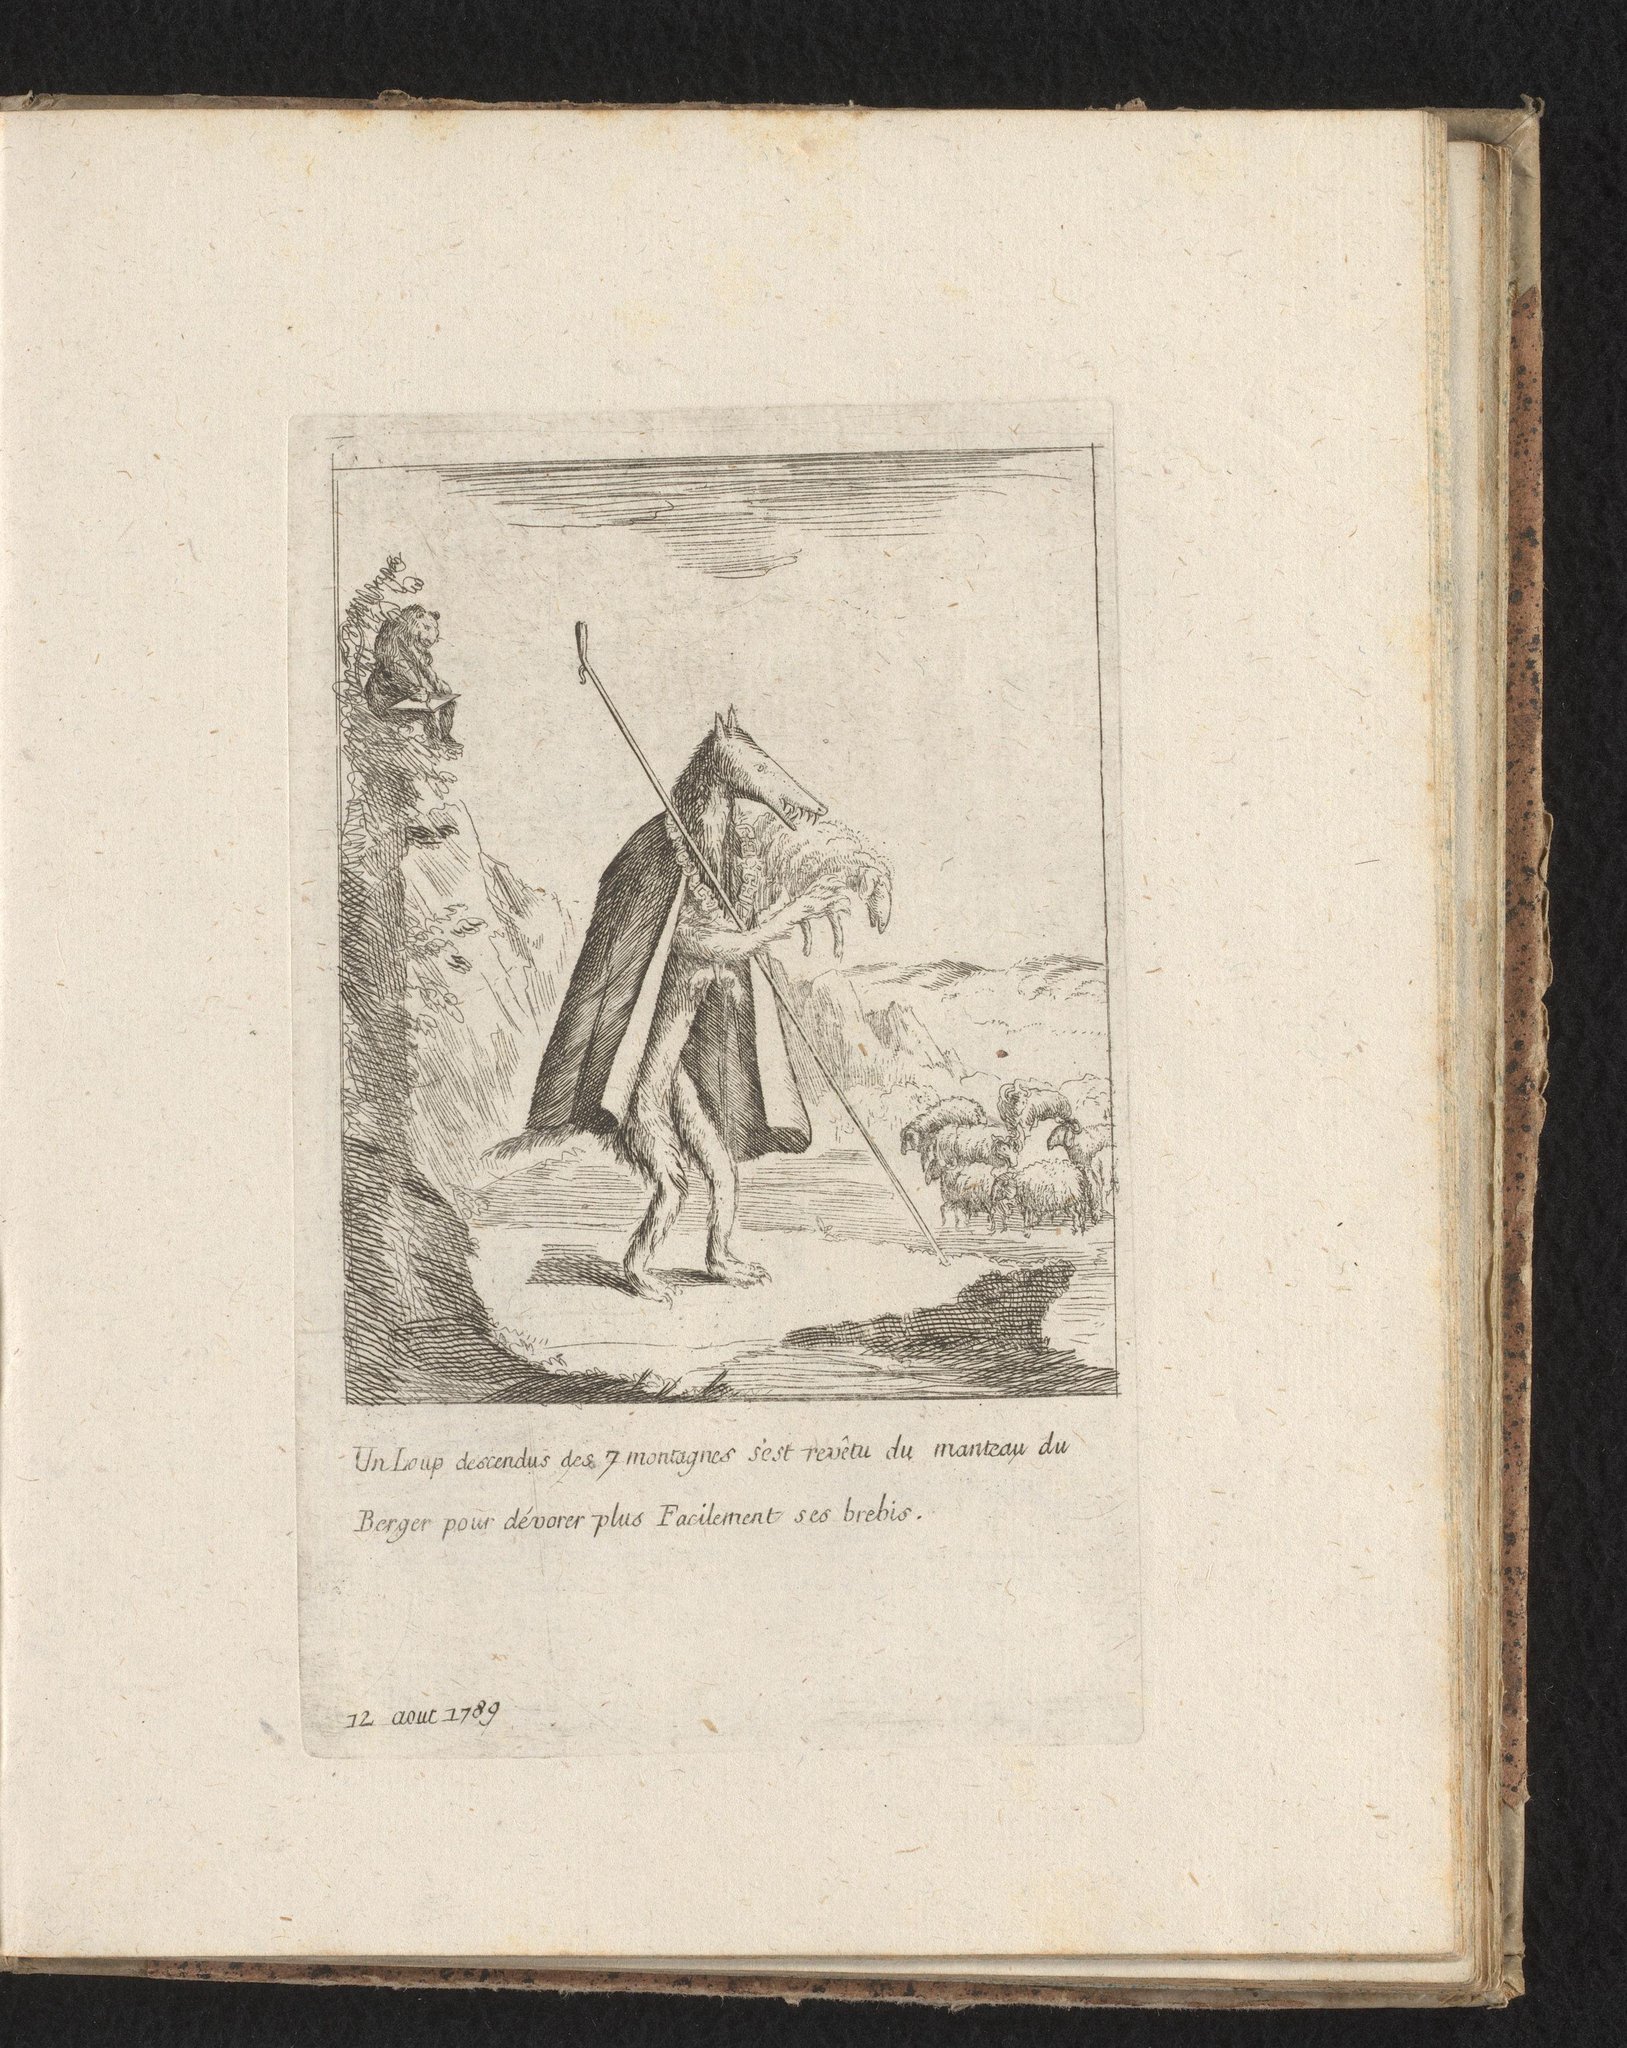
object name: cartoon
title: Jozef II als een wolf die een schaap verslindt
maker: Anonymous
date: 1787-1790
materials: paper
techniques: engraving, etching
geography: southern netherlands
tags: vienna, jozef ii (duits keizer), animals acting as human beings, wolf clothed as shepherd ~ parable of the good shepherd, brabant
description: Spotprent op de Oostenrijkse keizer Jozef II, hier in de gedaante van een wolf met het ordeteken van het Gulden Vlies die vermomd als een herder op het punt staat een schaap te verslinden. Gerelateeerd aan 12 augustus 1789. Met onderschrift van 2 regels in het Frans. Onderdeel van de gebundelde verzameling prenten betrekking hebbend op de gebeurtenissen van de Brabantse Omwenteling en de periode 1787-1790.